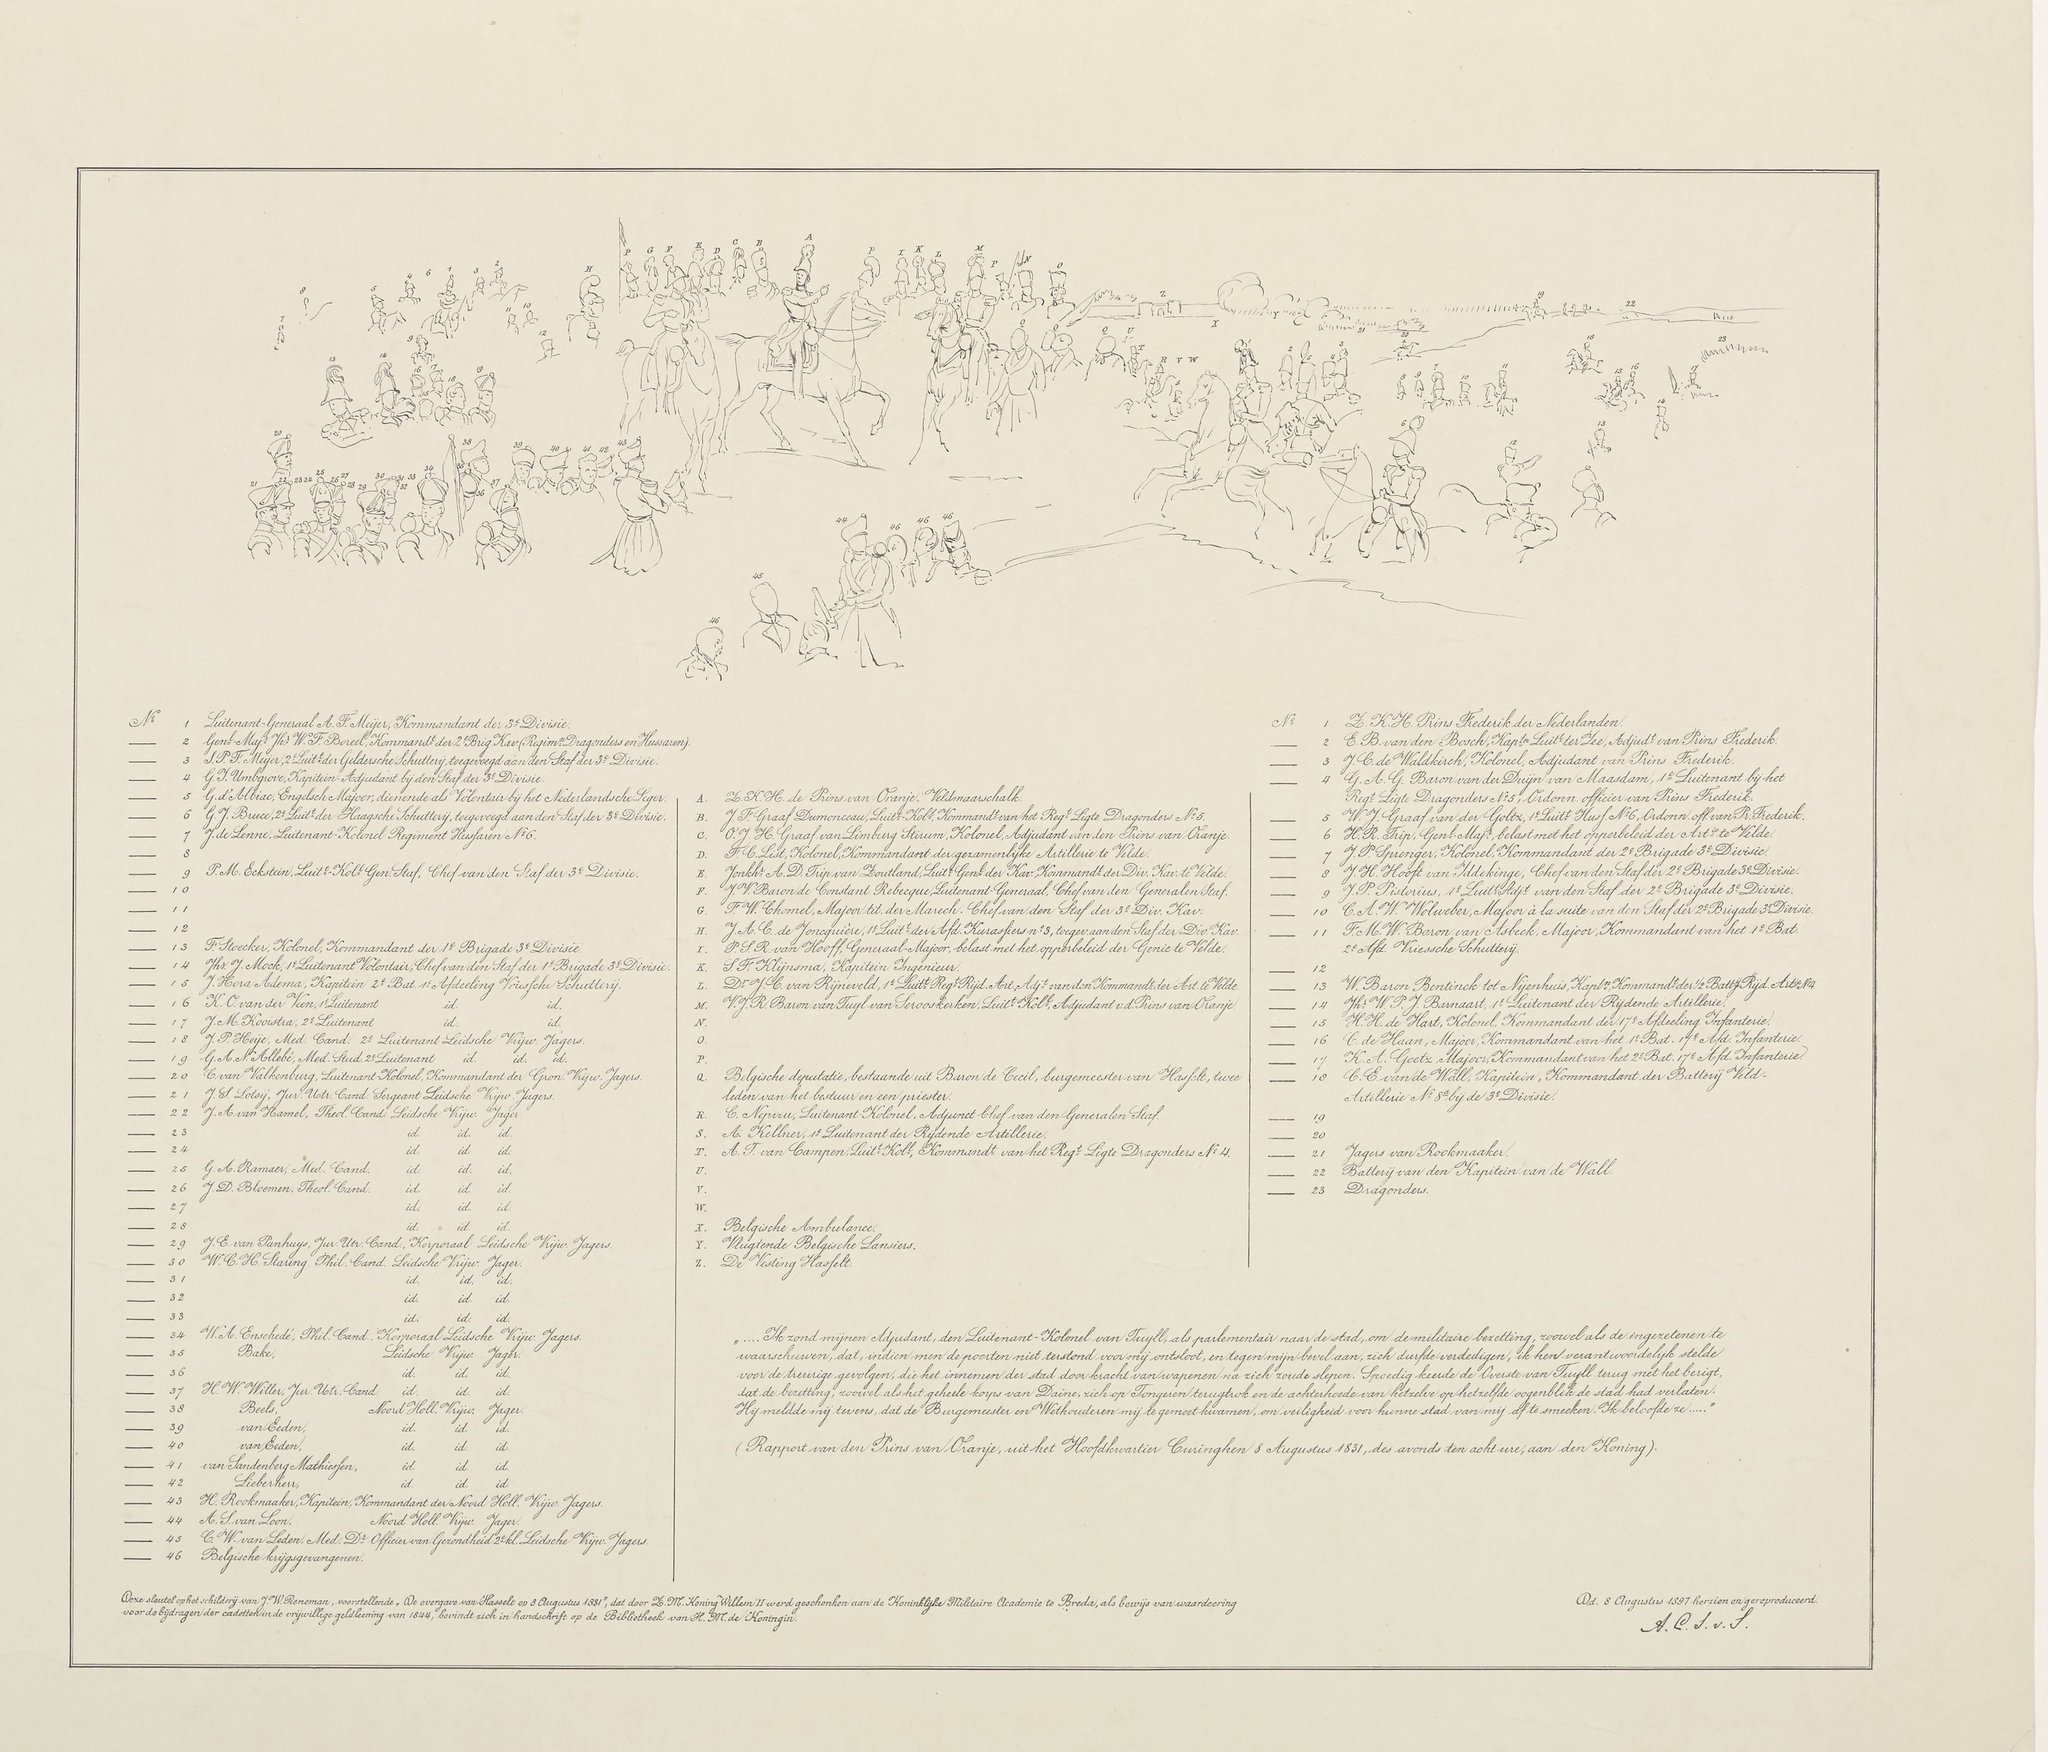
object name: print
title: Sleutel op het schilderij van De Overgave van Hasselt op 8 Augustus 1831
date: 1897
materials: paper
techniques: lithograph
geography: netherlands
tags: william ii of the netherlands, berlin, frederik (prins der nederlanden), battle (+ land forces)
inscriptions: collector's mark: Lugt 2228, date and inscription: ‘D.d.8 Augustus 1897 herzien en gereproduceerd. A.C.S.v.S.’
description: Sleutel op het schilderij van de overgave van de stad Hasselt aan de Nederlandse troepen onder bevel van de prins van Oranje, 8 augustus 1831. In de sleutel de namen van de afgebeelde personen in drie kolommen 1-46, A-Z en 1-23. Deze sleutel uit 1897 is een reproductie naar een sleutel in manuscript uit 1844.